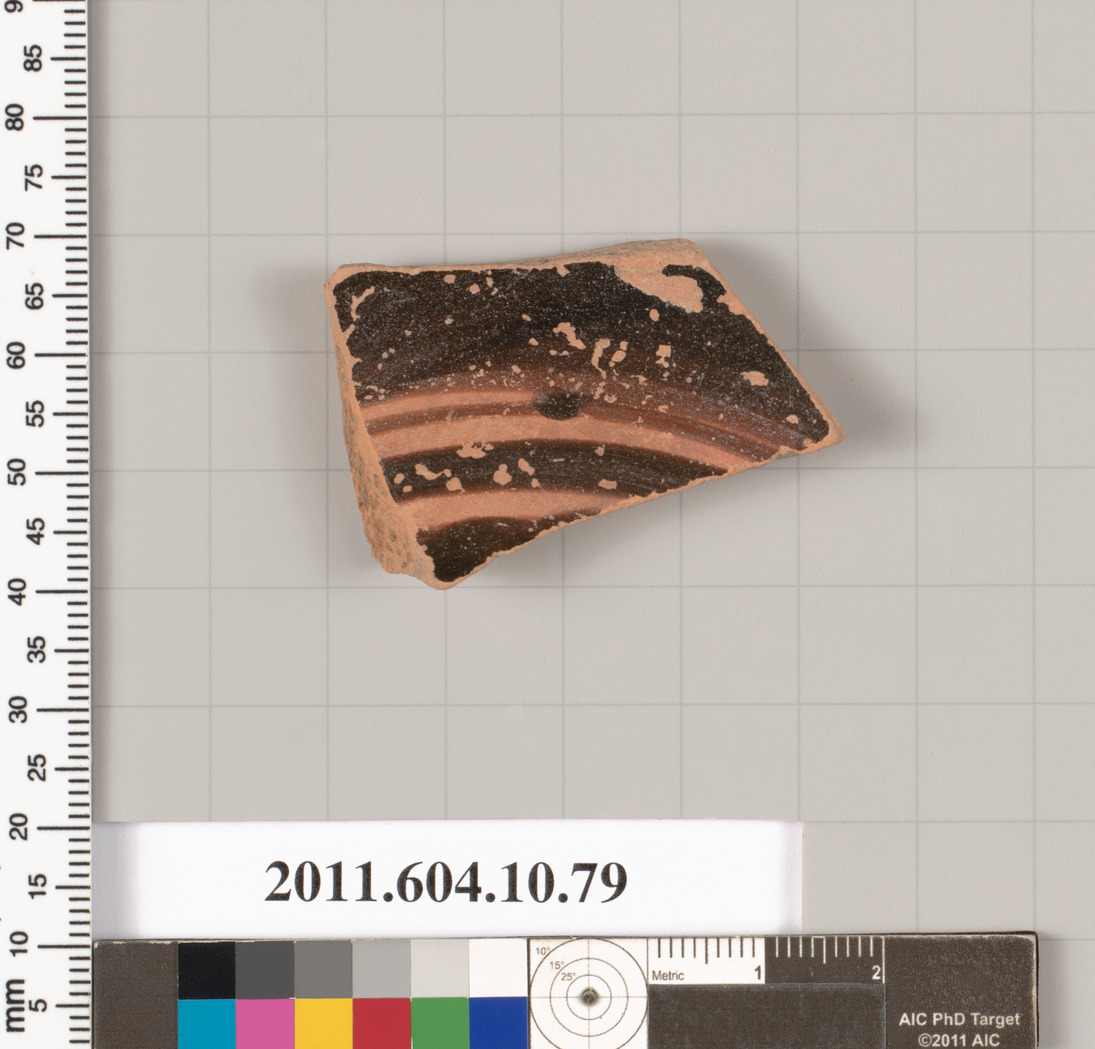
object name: fragment of a bowl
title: Terracotta fragment of a bowl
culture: etruscan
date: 400-301 BCE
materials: terracotta